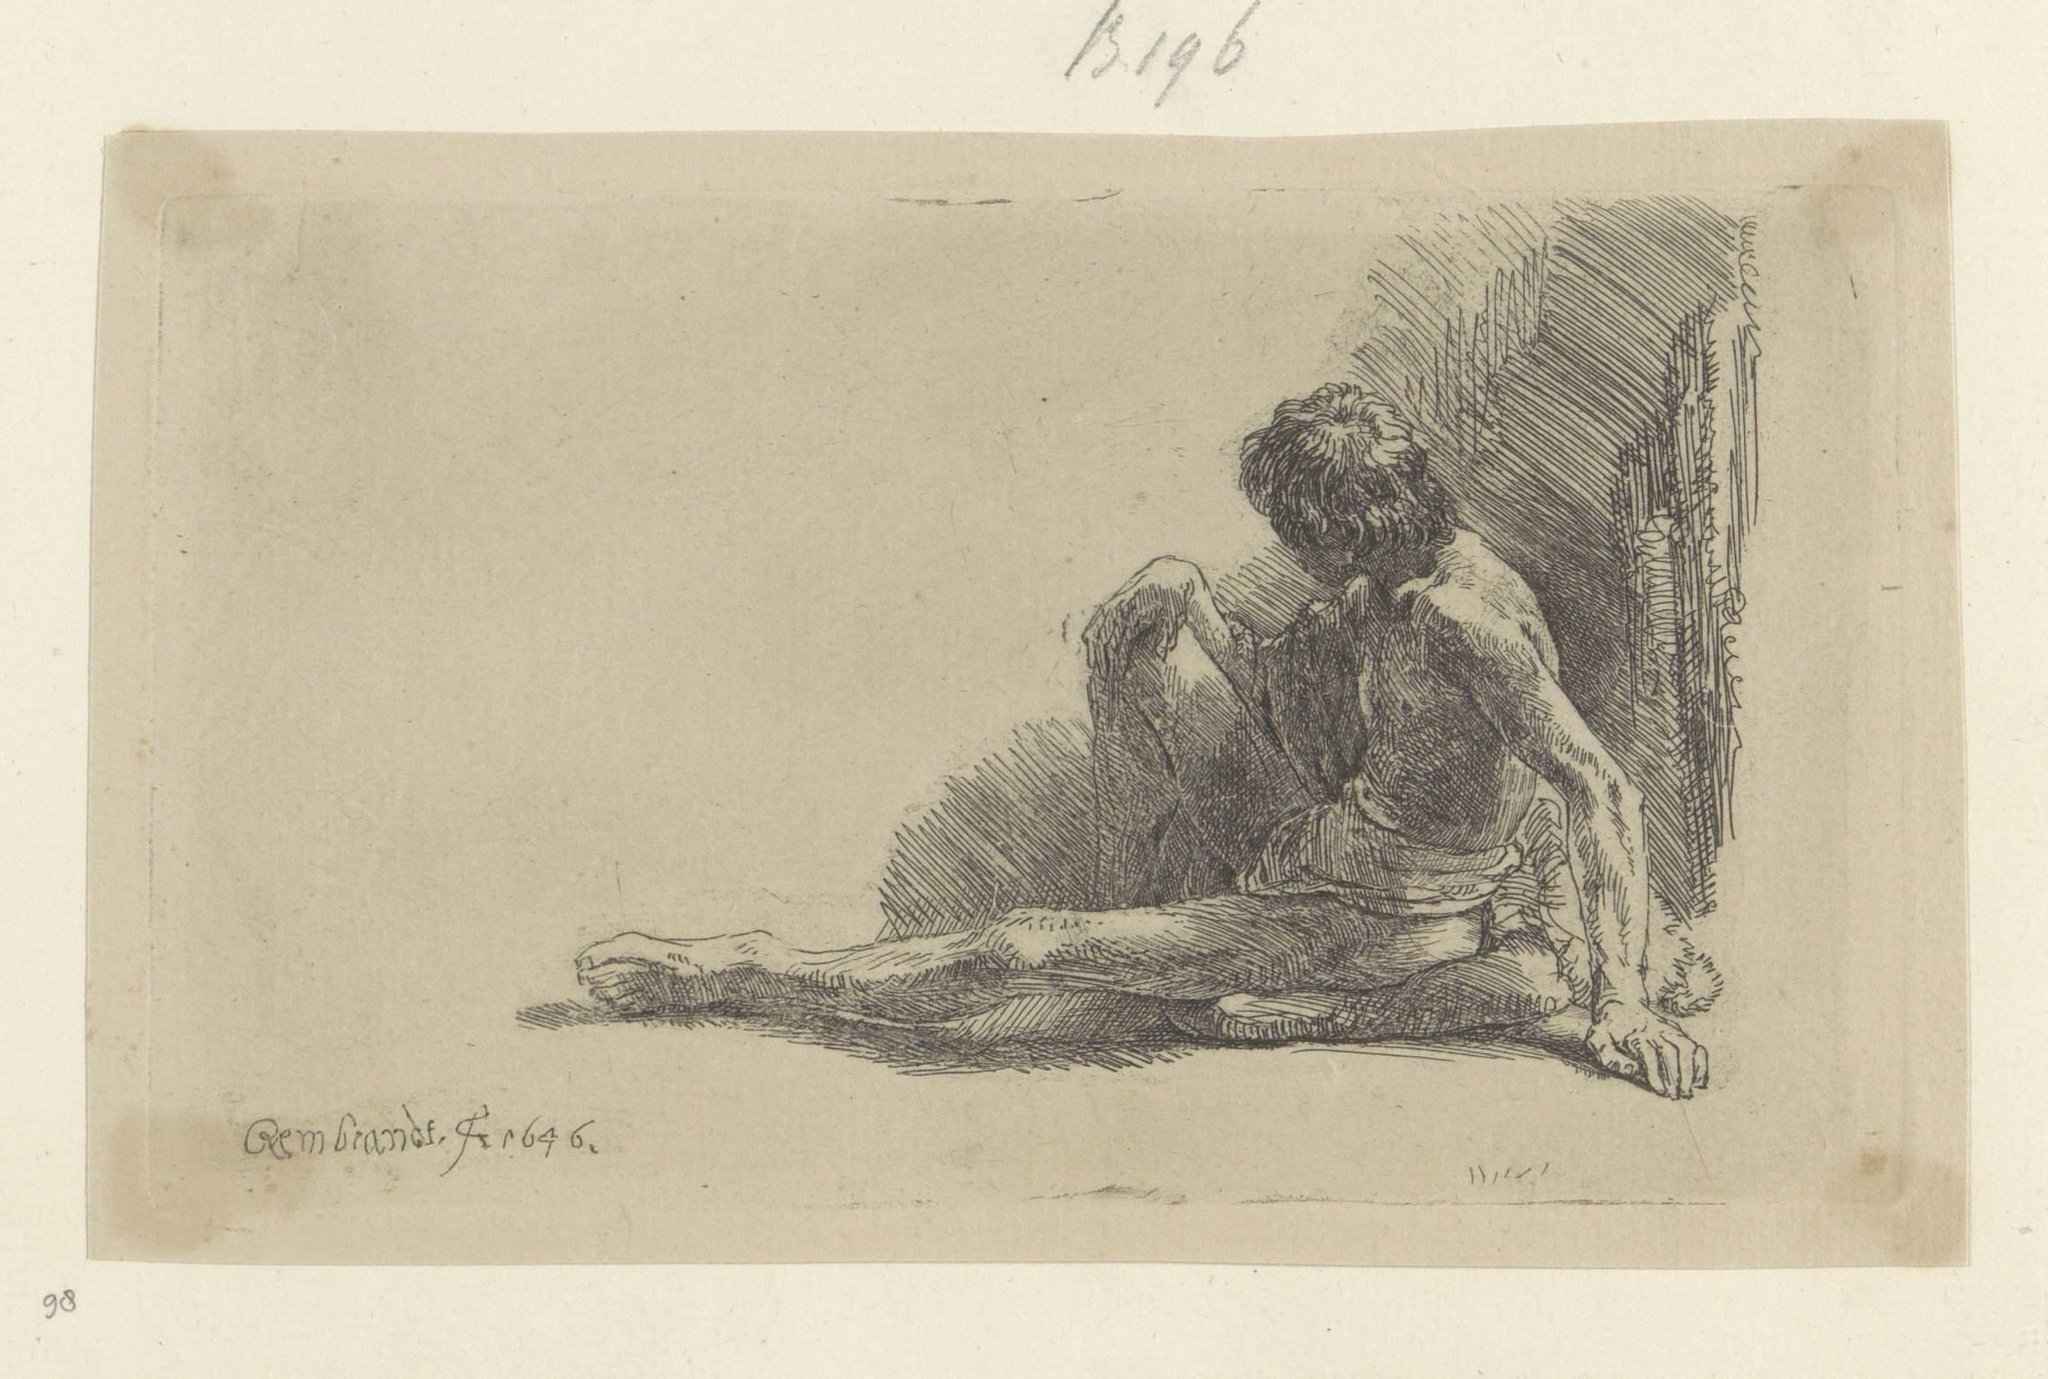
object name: print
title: Jonge man, zittend op de grond met één been uitgestrekt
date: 1646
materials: paper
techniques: engraving, etching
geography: paris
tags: male sex; man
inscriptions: date